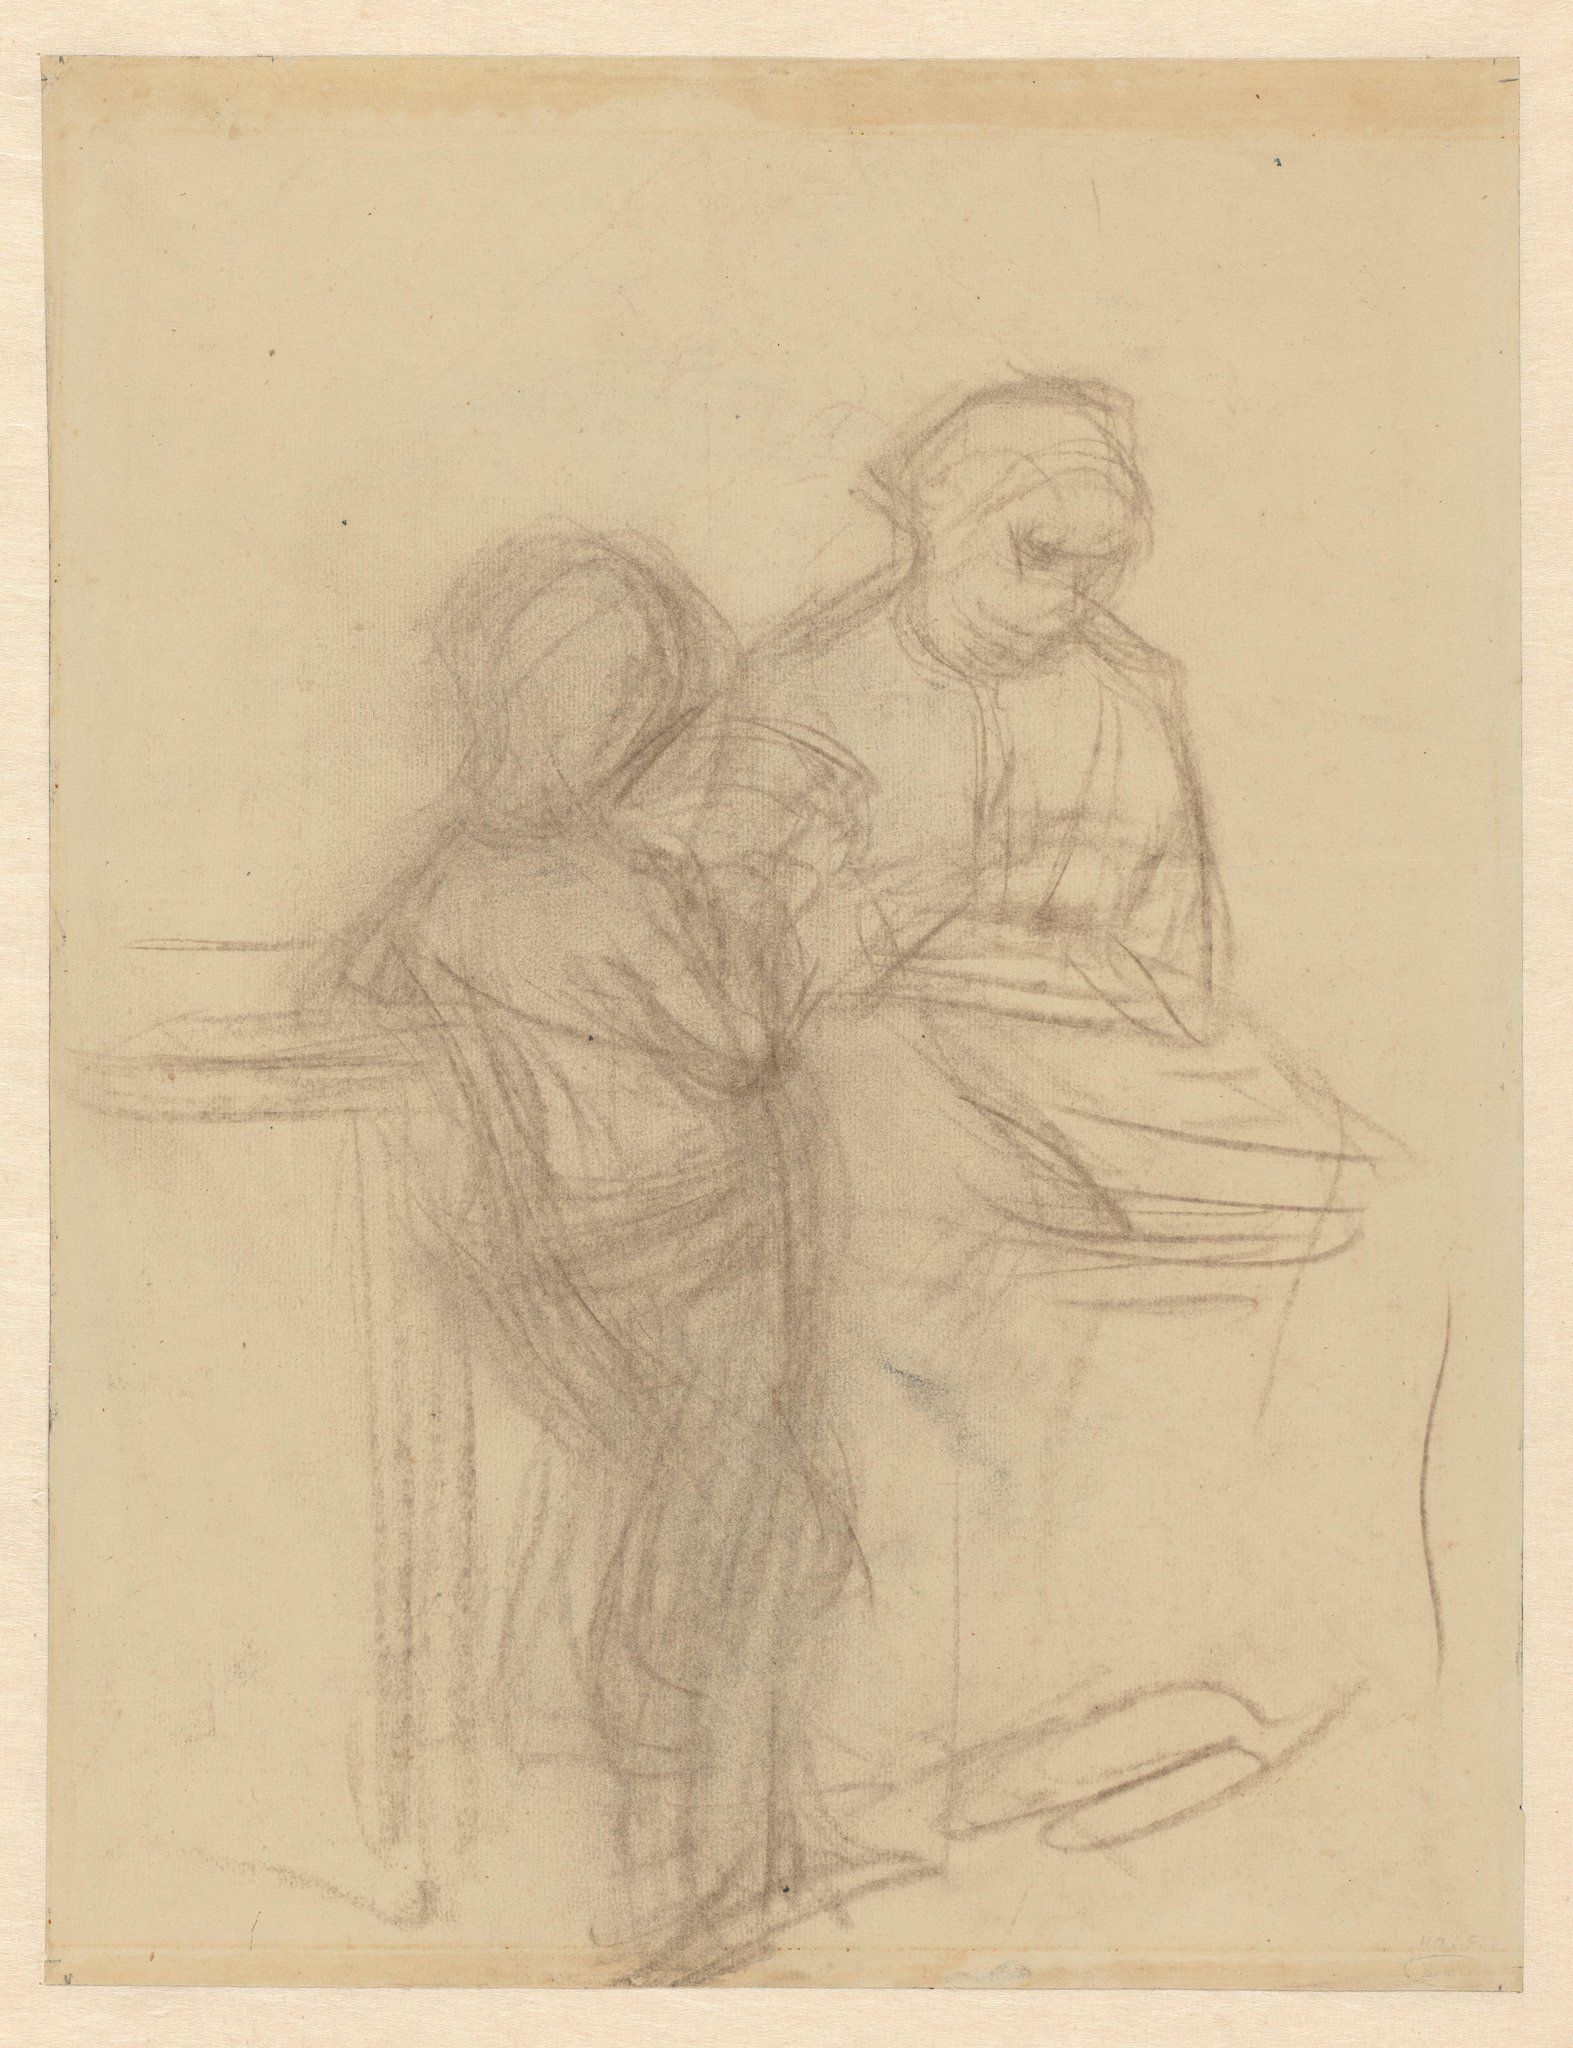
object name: drawing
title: Zittende vrouw en staand kind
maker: bernardus johannes blommers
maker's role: draughtsman, print maker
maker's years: 1845-1914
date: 1855-1914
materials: charcoal, paper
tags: mother and baby or young child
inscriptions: collector's mark: Lugt 2228